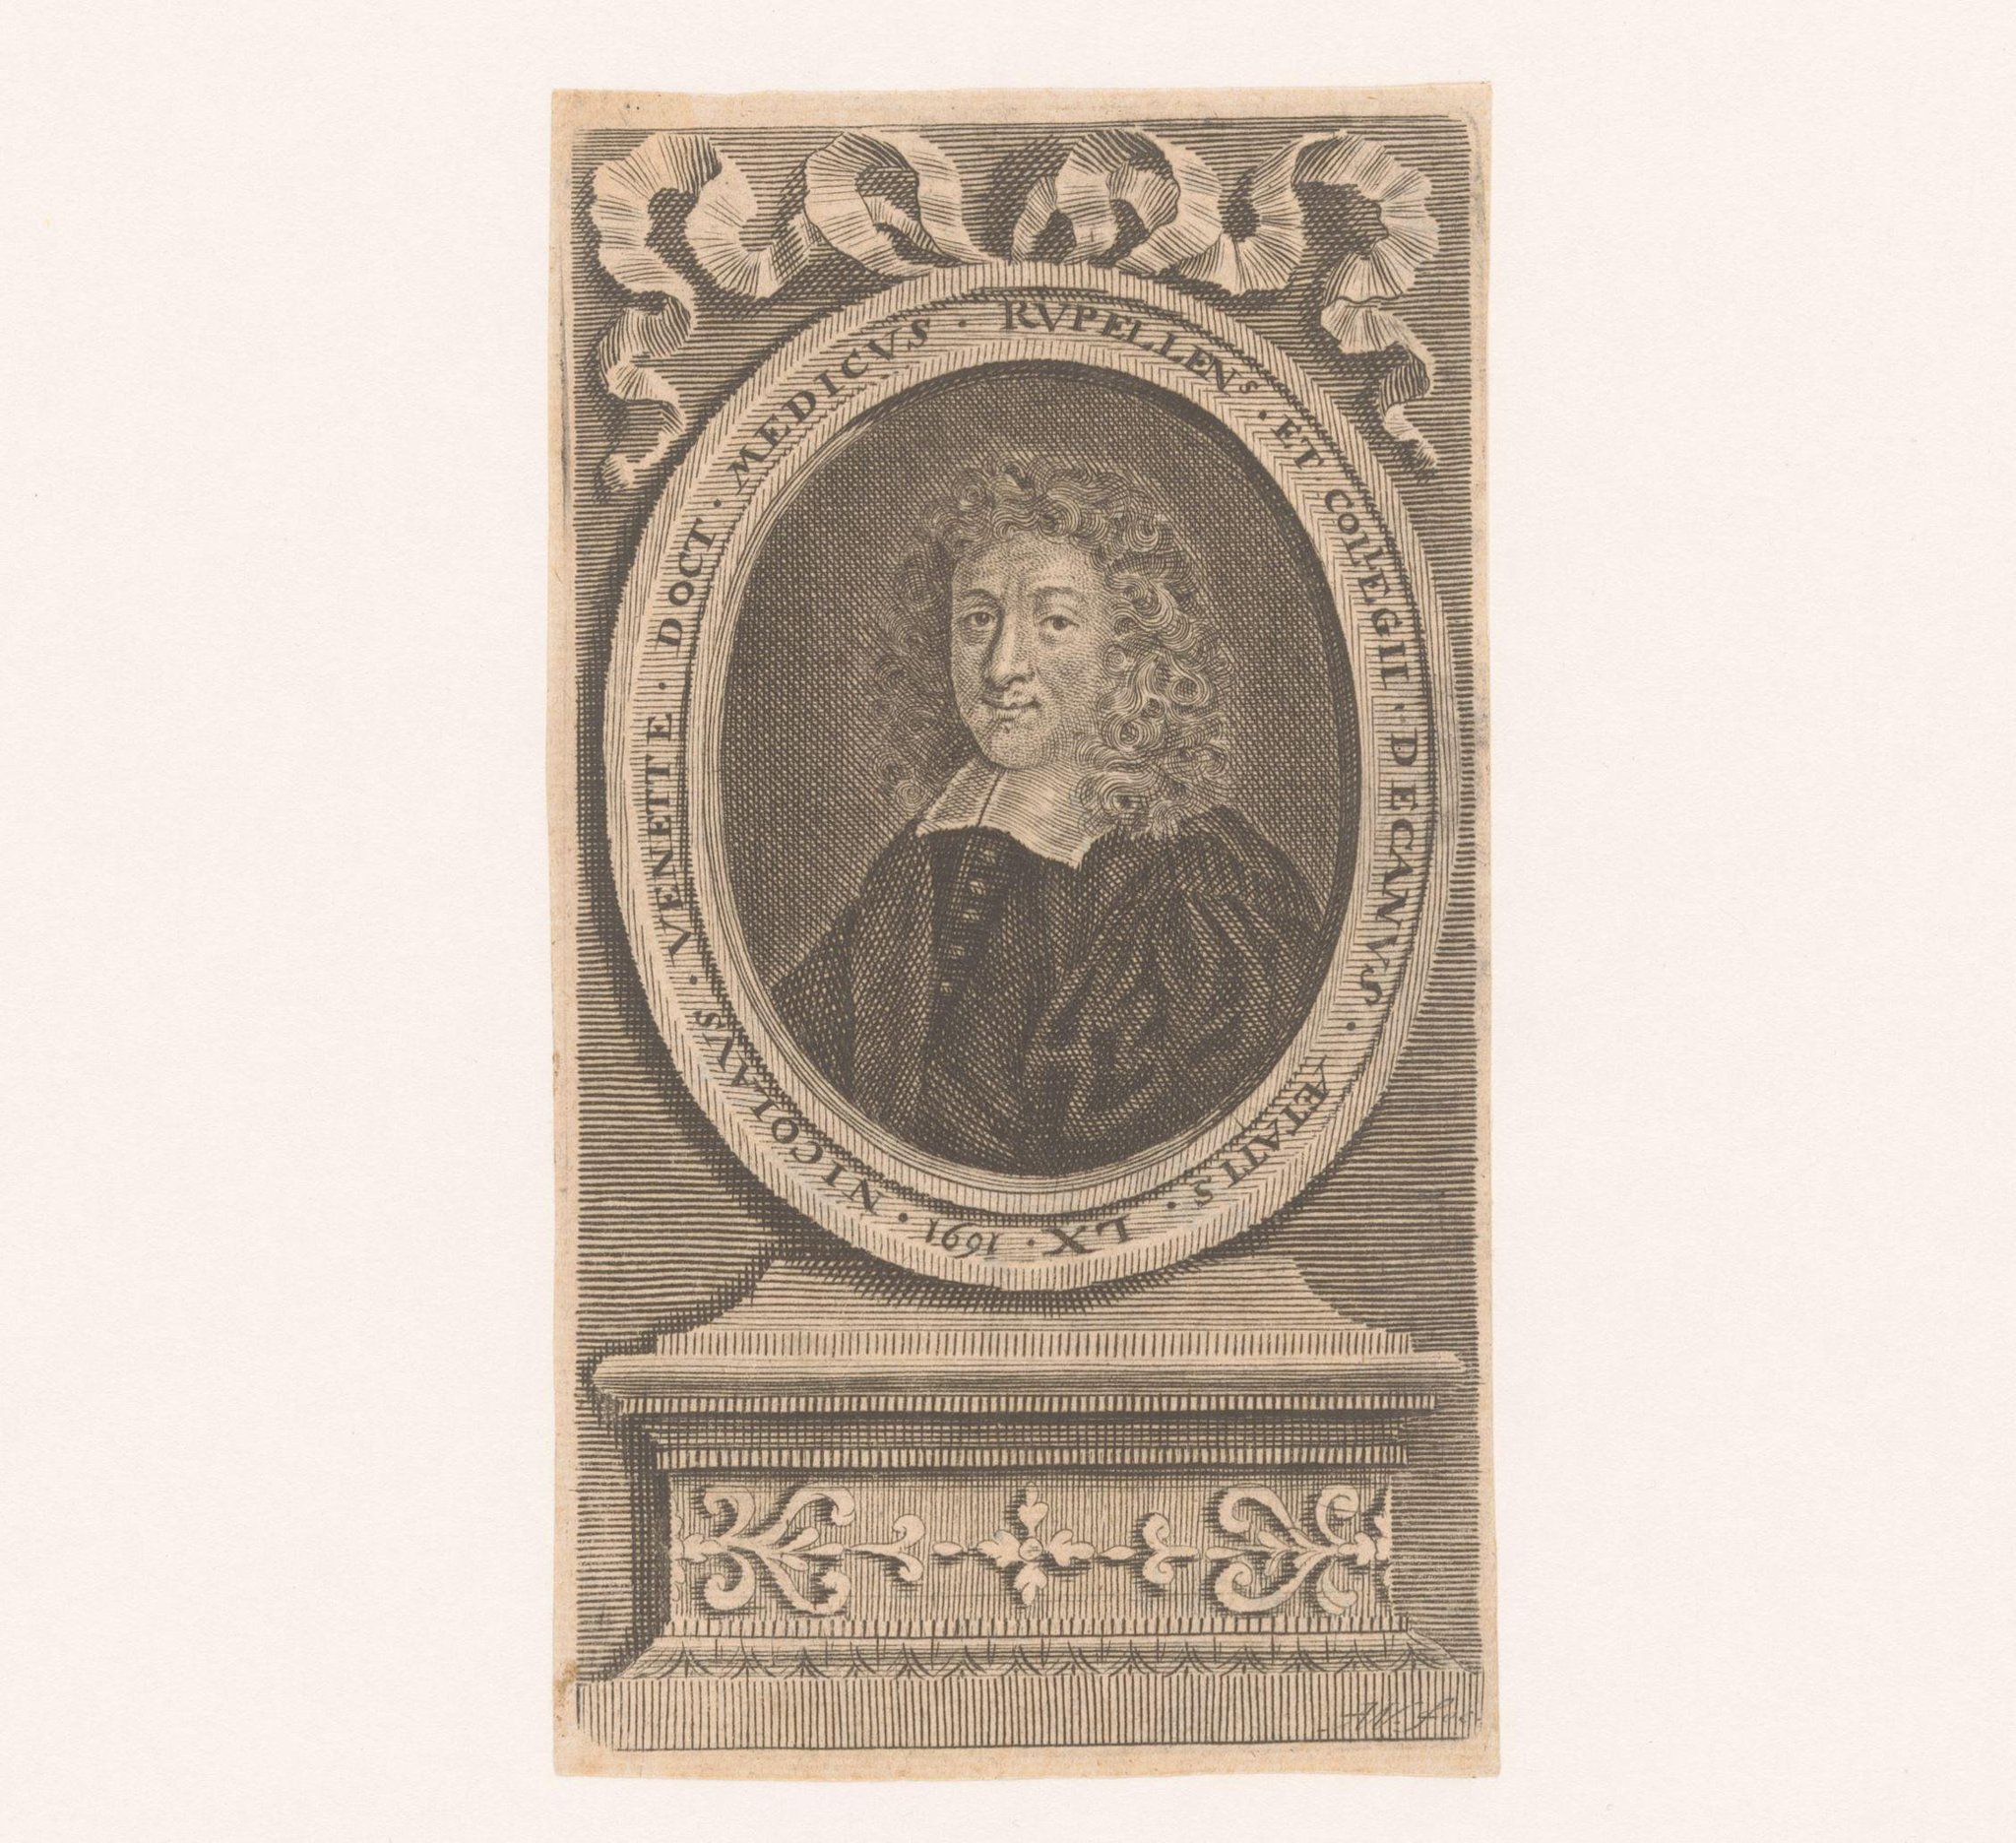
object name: print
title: Portret van Nicolas Venette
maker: monogrammist aw (17e eeuw)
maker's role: print maker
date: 1691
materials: paper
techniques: engraving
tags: historical persons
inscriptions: collector's mark: Lugt 2228